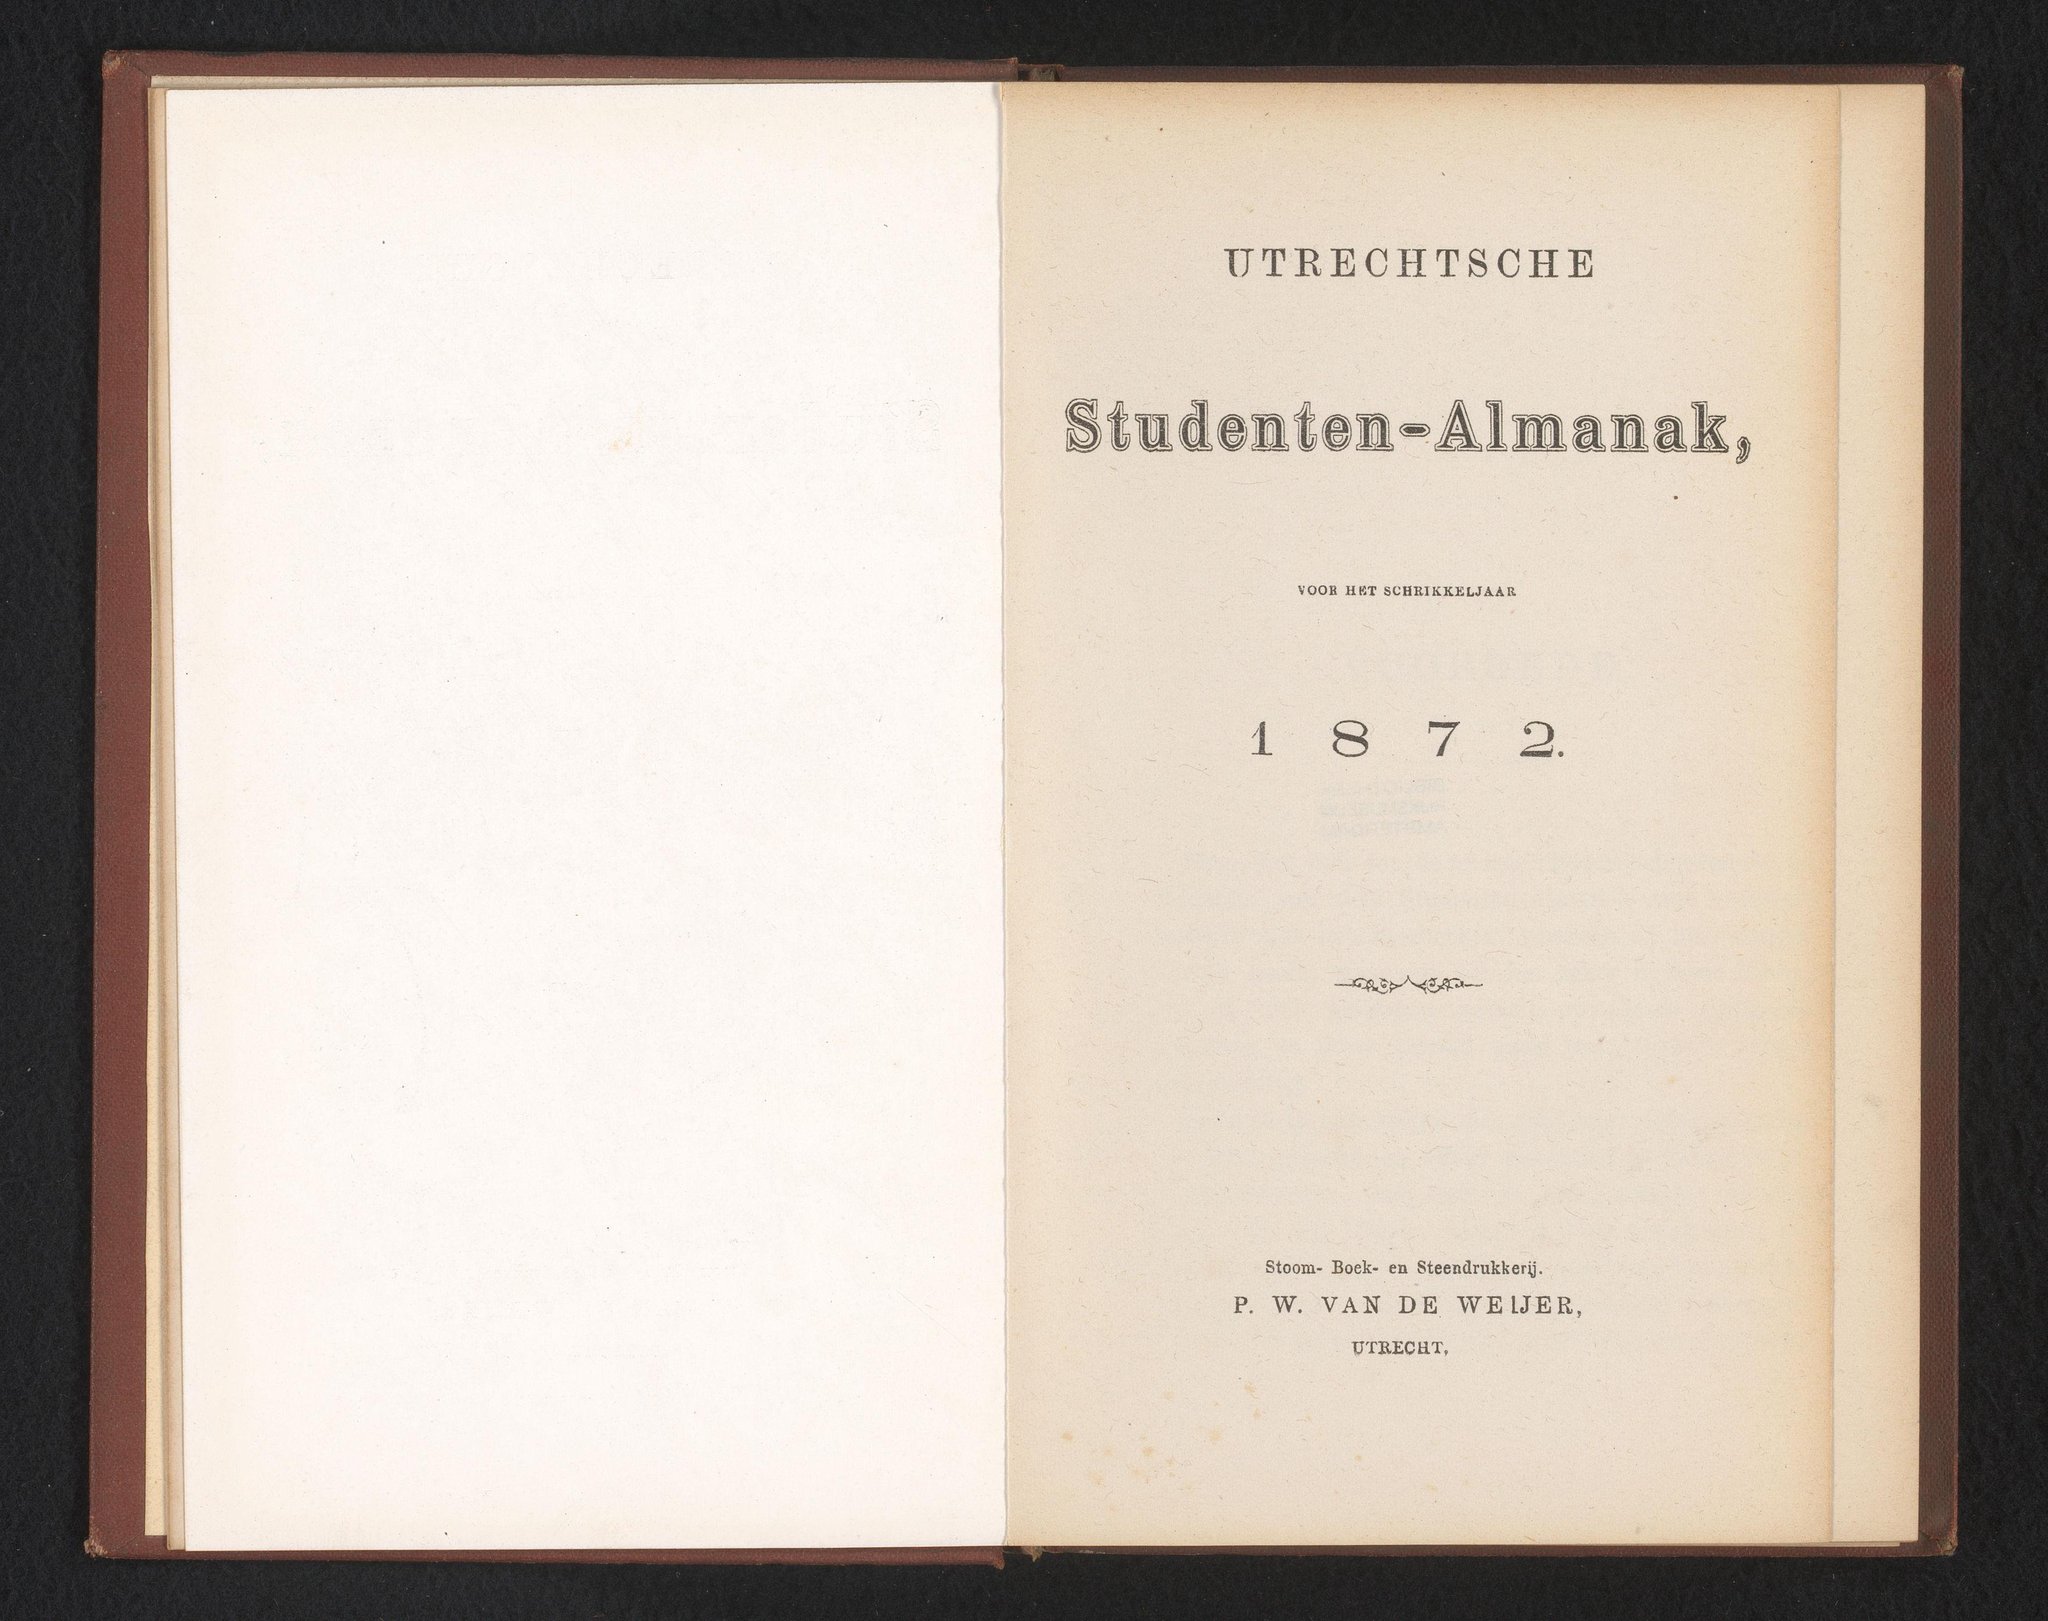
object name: book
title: Utrechtsche studenten-almanak voor het schrikkeljaar 1872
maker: pieter wilhelmus van de weijer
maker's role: print maker, printer, publisher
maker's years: 1816-1880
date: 1871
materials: paper, cardboard, leather, linen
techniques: lithograph, engraving, letterpress printing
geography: utrecht